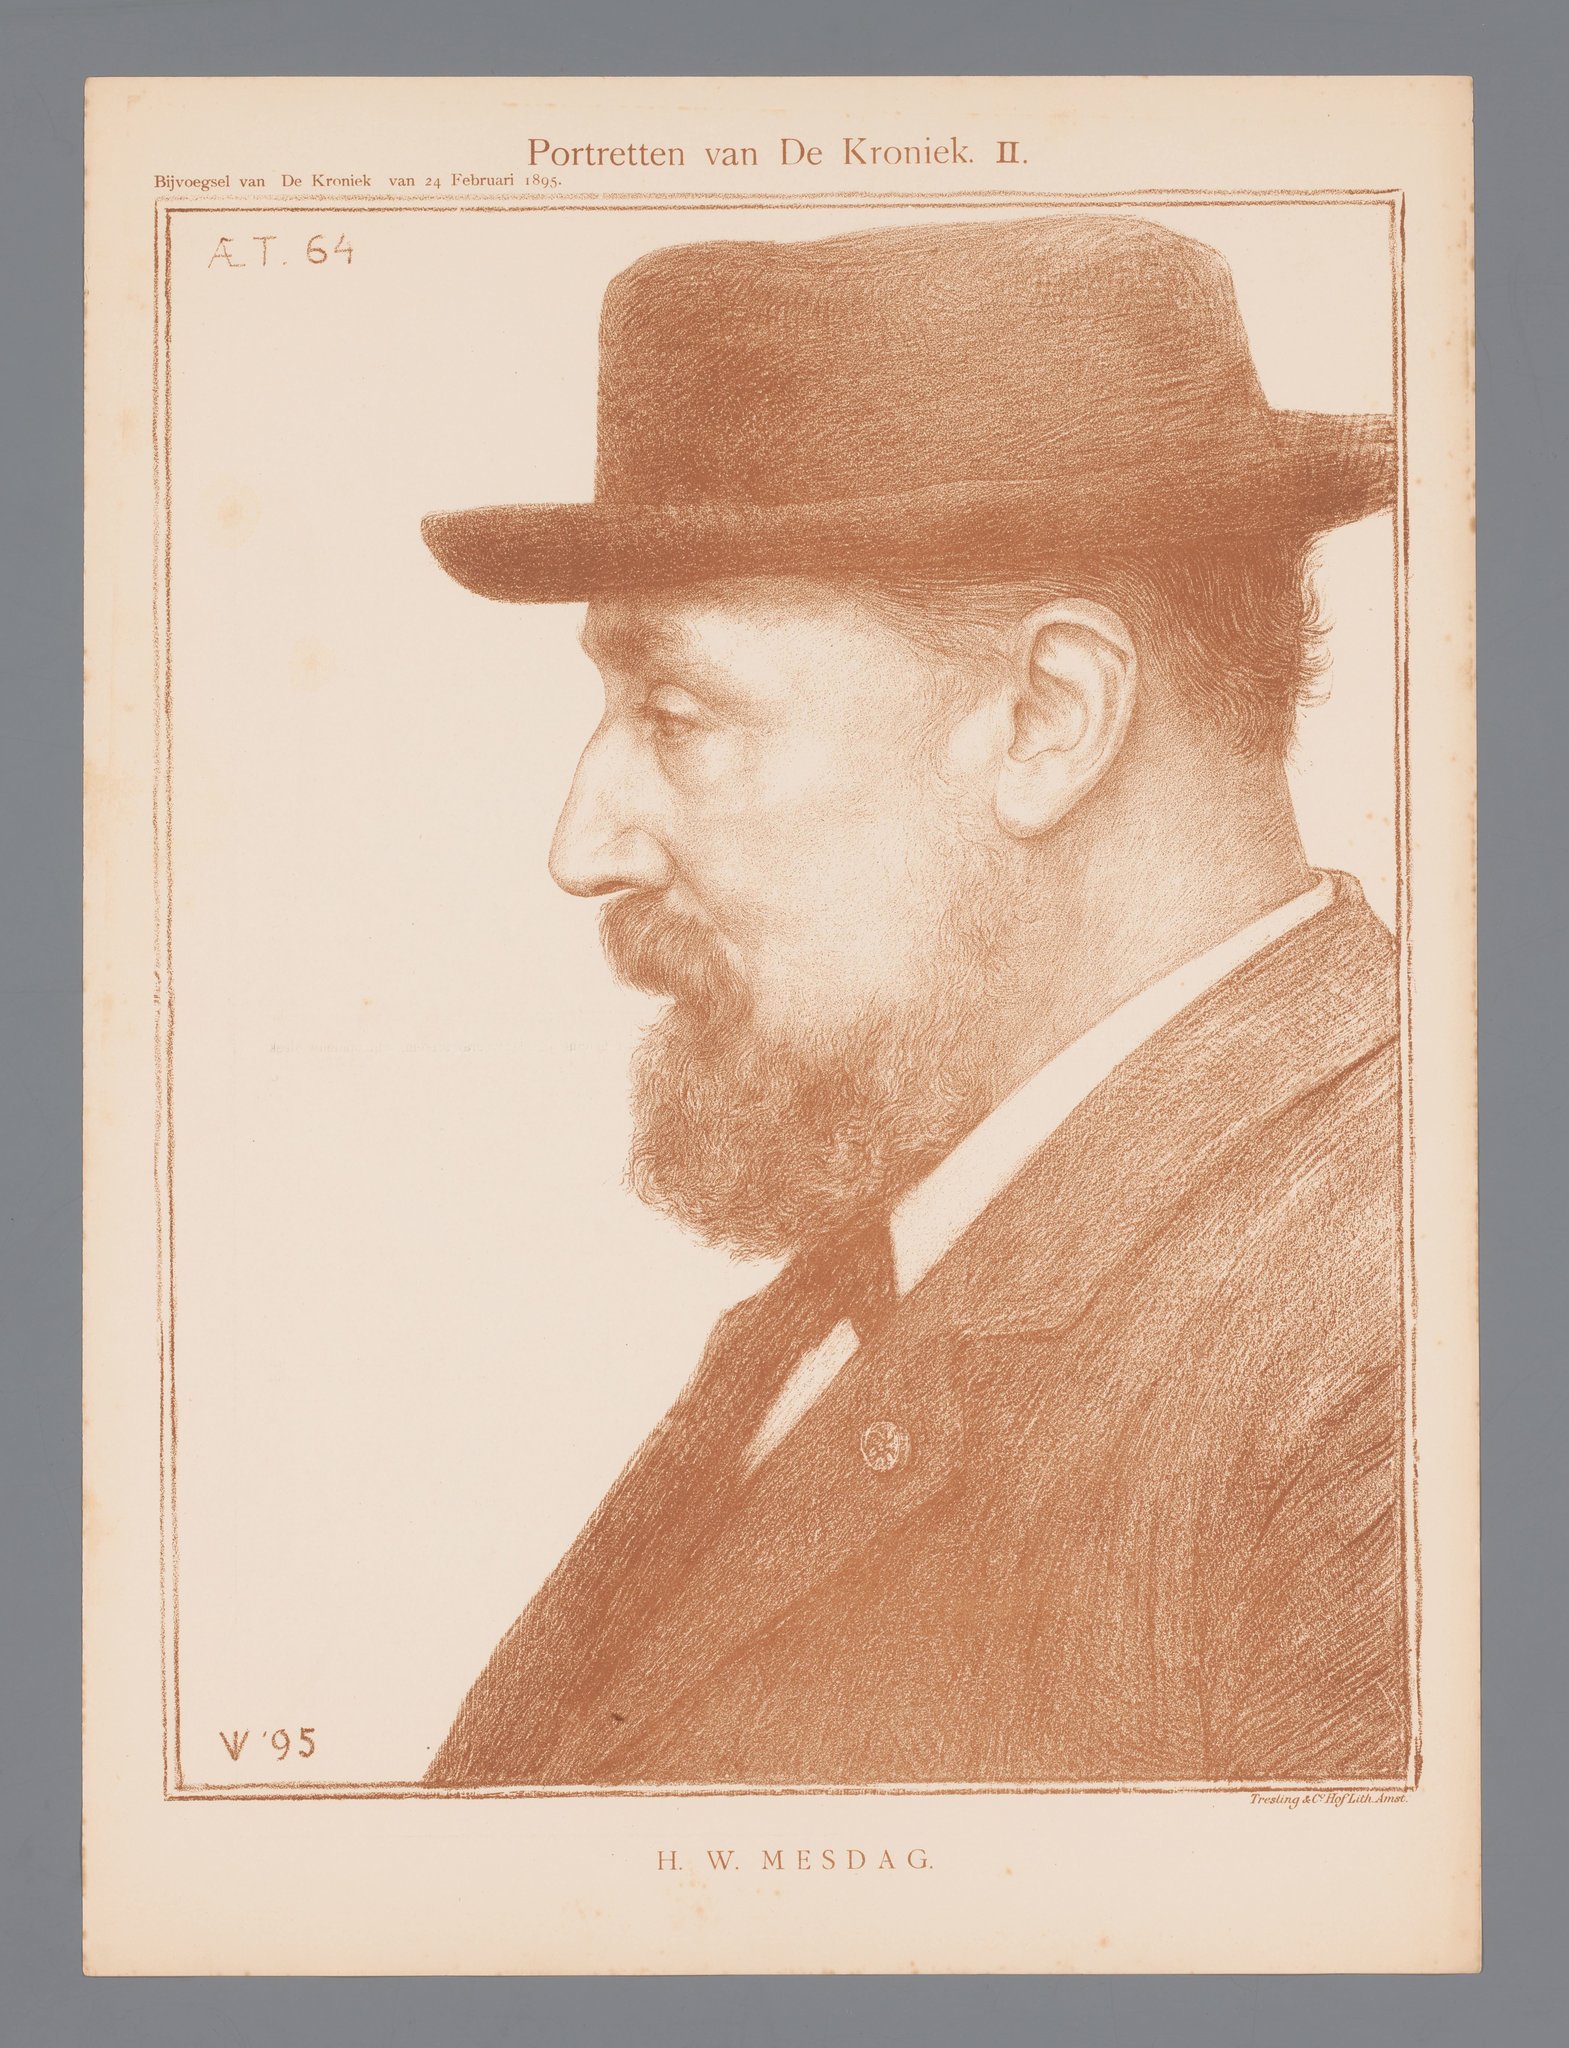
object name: print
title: Portretten van De Kroniek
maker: jan veth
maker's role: designer, draughtsman, painter, print maker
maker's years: 1864-1925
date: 1895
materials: paper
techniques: lithograph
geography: amsterdam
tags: the hague, painter, print maker, draughtsman, hendrik willem mesdag, historical persons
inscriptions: date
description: Prent uit het bijvoegsel van: De Kroniek 1 (1895), 24 februari 1895.